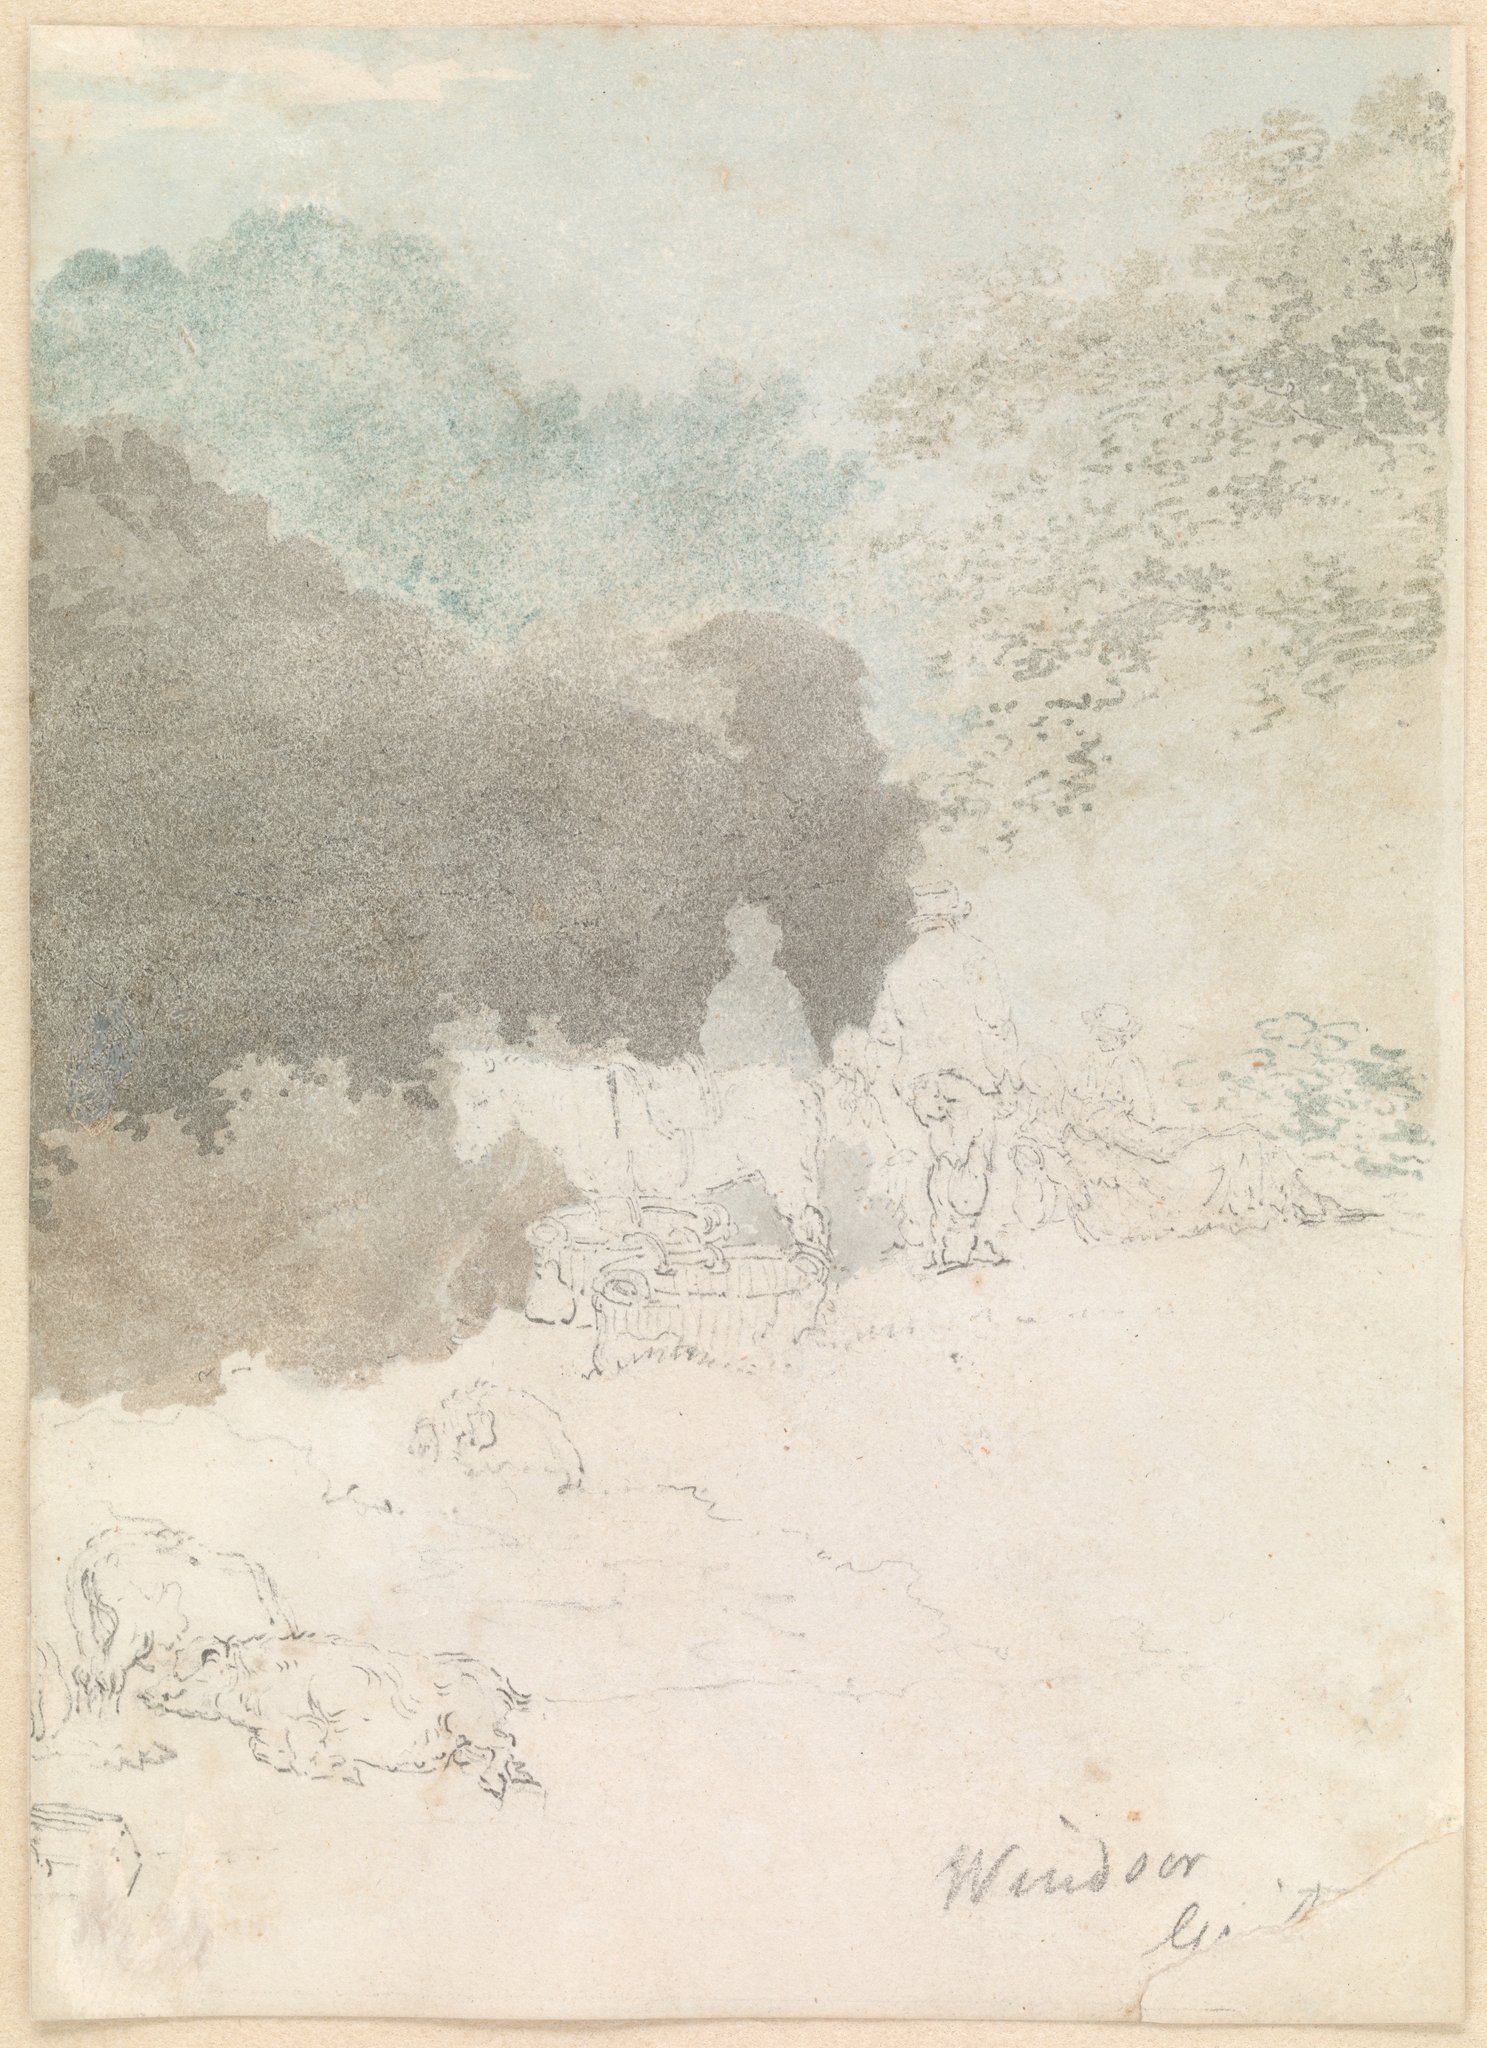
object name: drawing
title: Horses and pigs in a landscape, Windsor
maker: thomas girtin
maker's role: artist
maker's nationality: british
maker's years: 1775-1802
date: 1793-1794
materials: graphite, watercolor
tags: horses,pigs